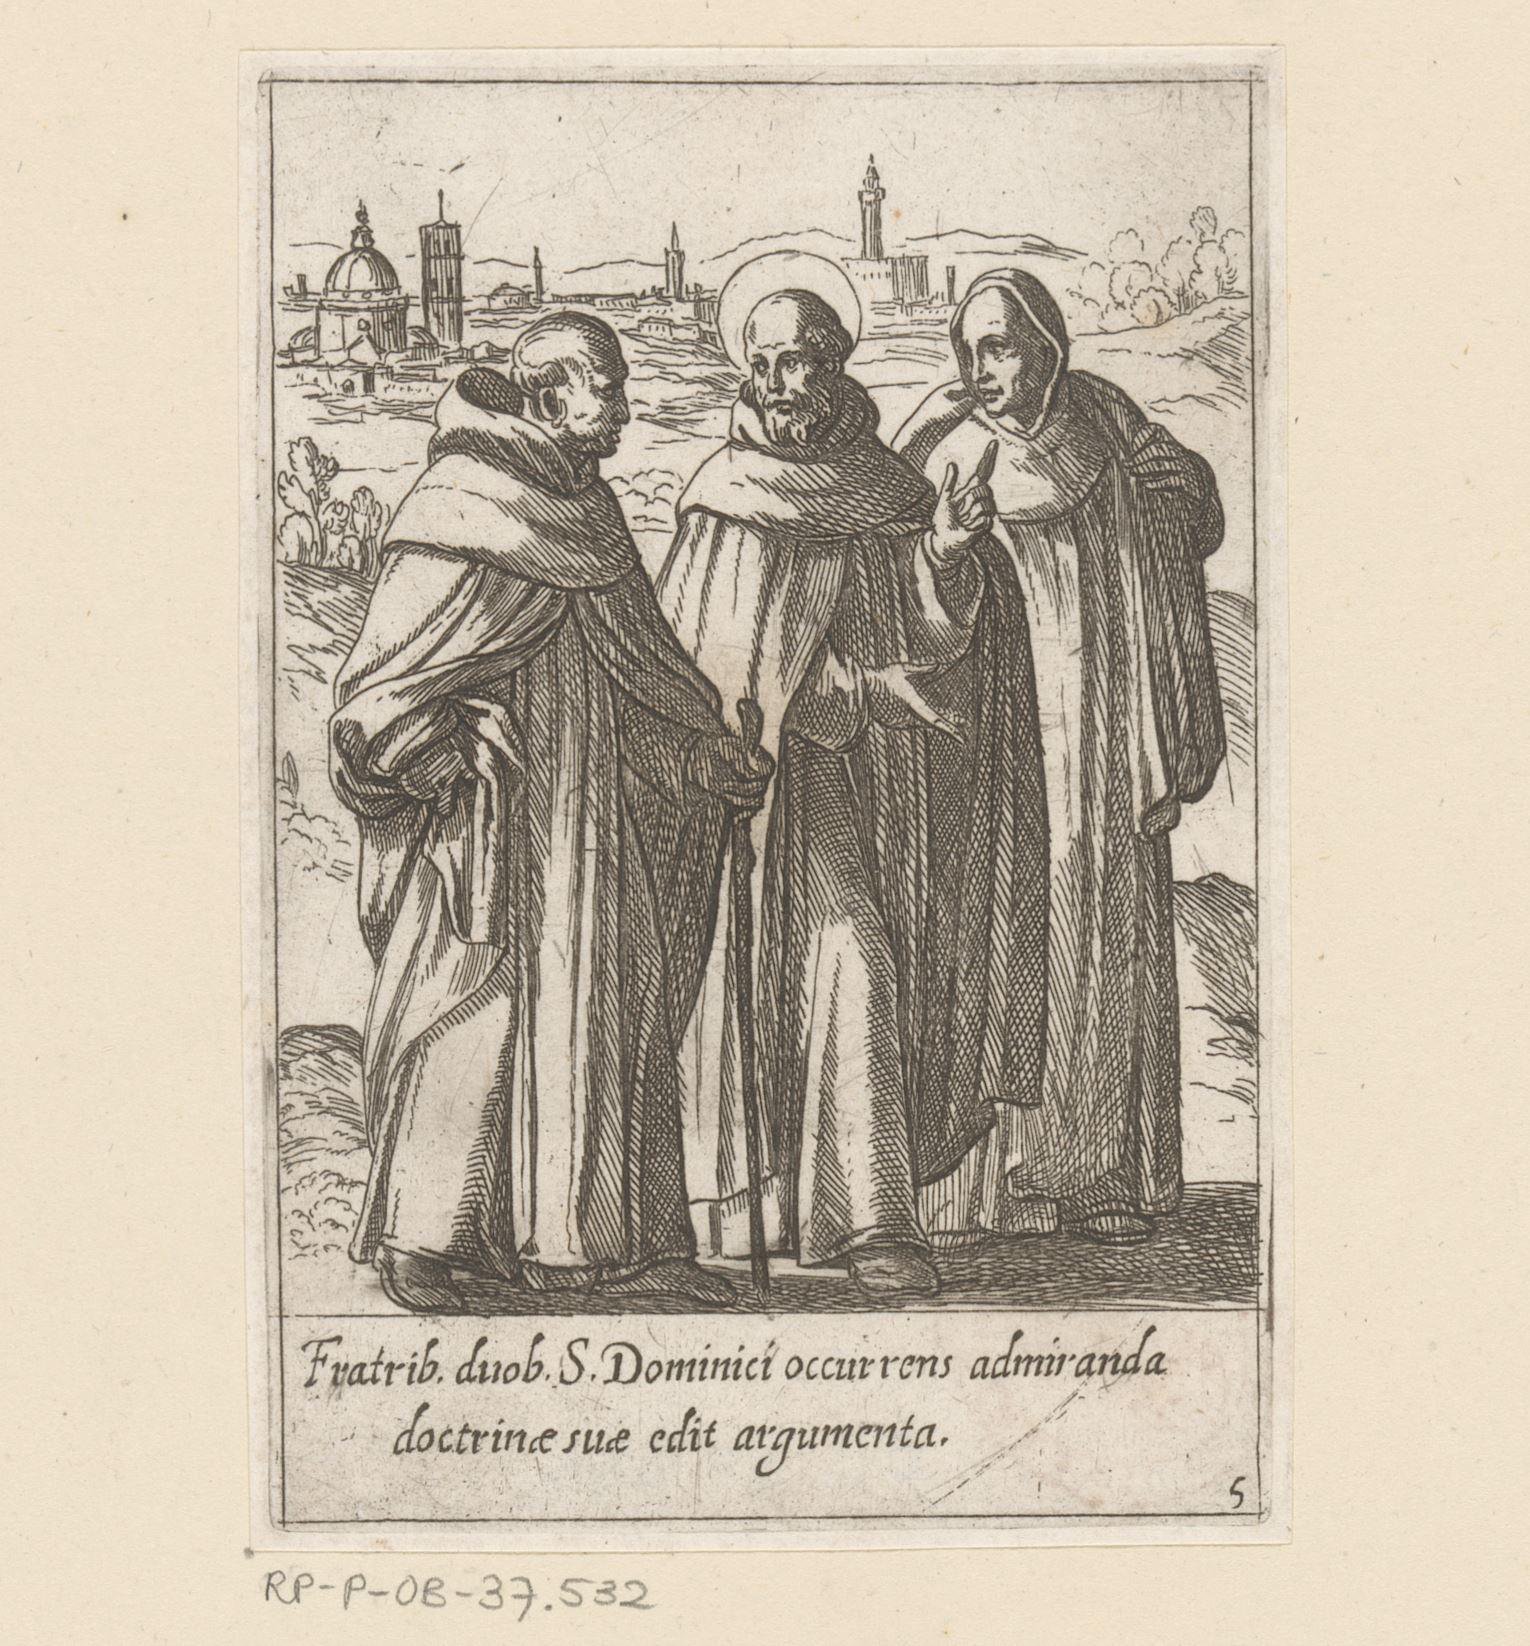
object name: print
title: Het Leven van Philippus Benitius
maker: antonio tempesta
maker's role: draughtsman, painter, print maker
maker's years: 1555-1630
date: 1591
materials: paper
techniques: etching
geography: vatican city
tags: clergyman, prior general of the order of the servites, philip benizzi of florence; possible attributes: book, cross, lily, tiara at his feet, monastic orders, monastic life: dominicans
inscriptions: collector's mark: Lugt 240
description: De heilige Philippus toont zijn vaardigheden in gesprek met twee dominicanen. Tekst in het Latijn in ondermarge. Genummerd rechtsonder: 5.